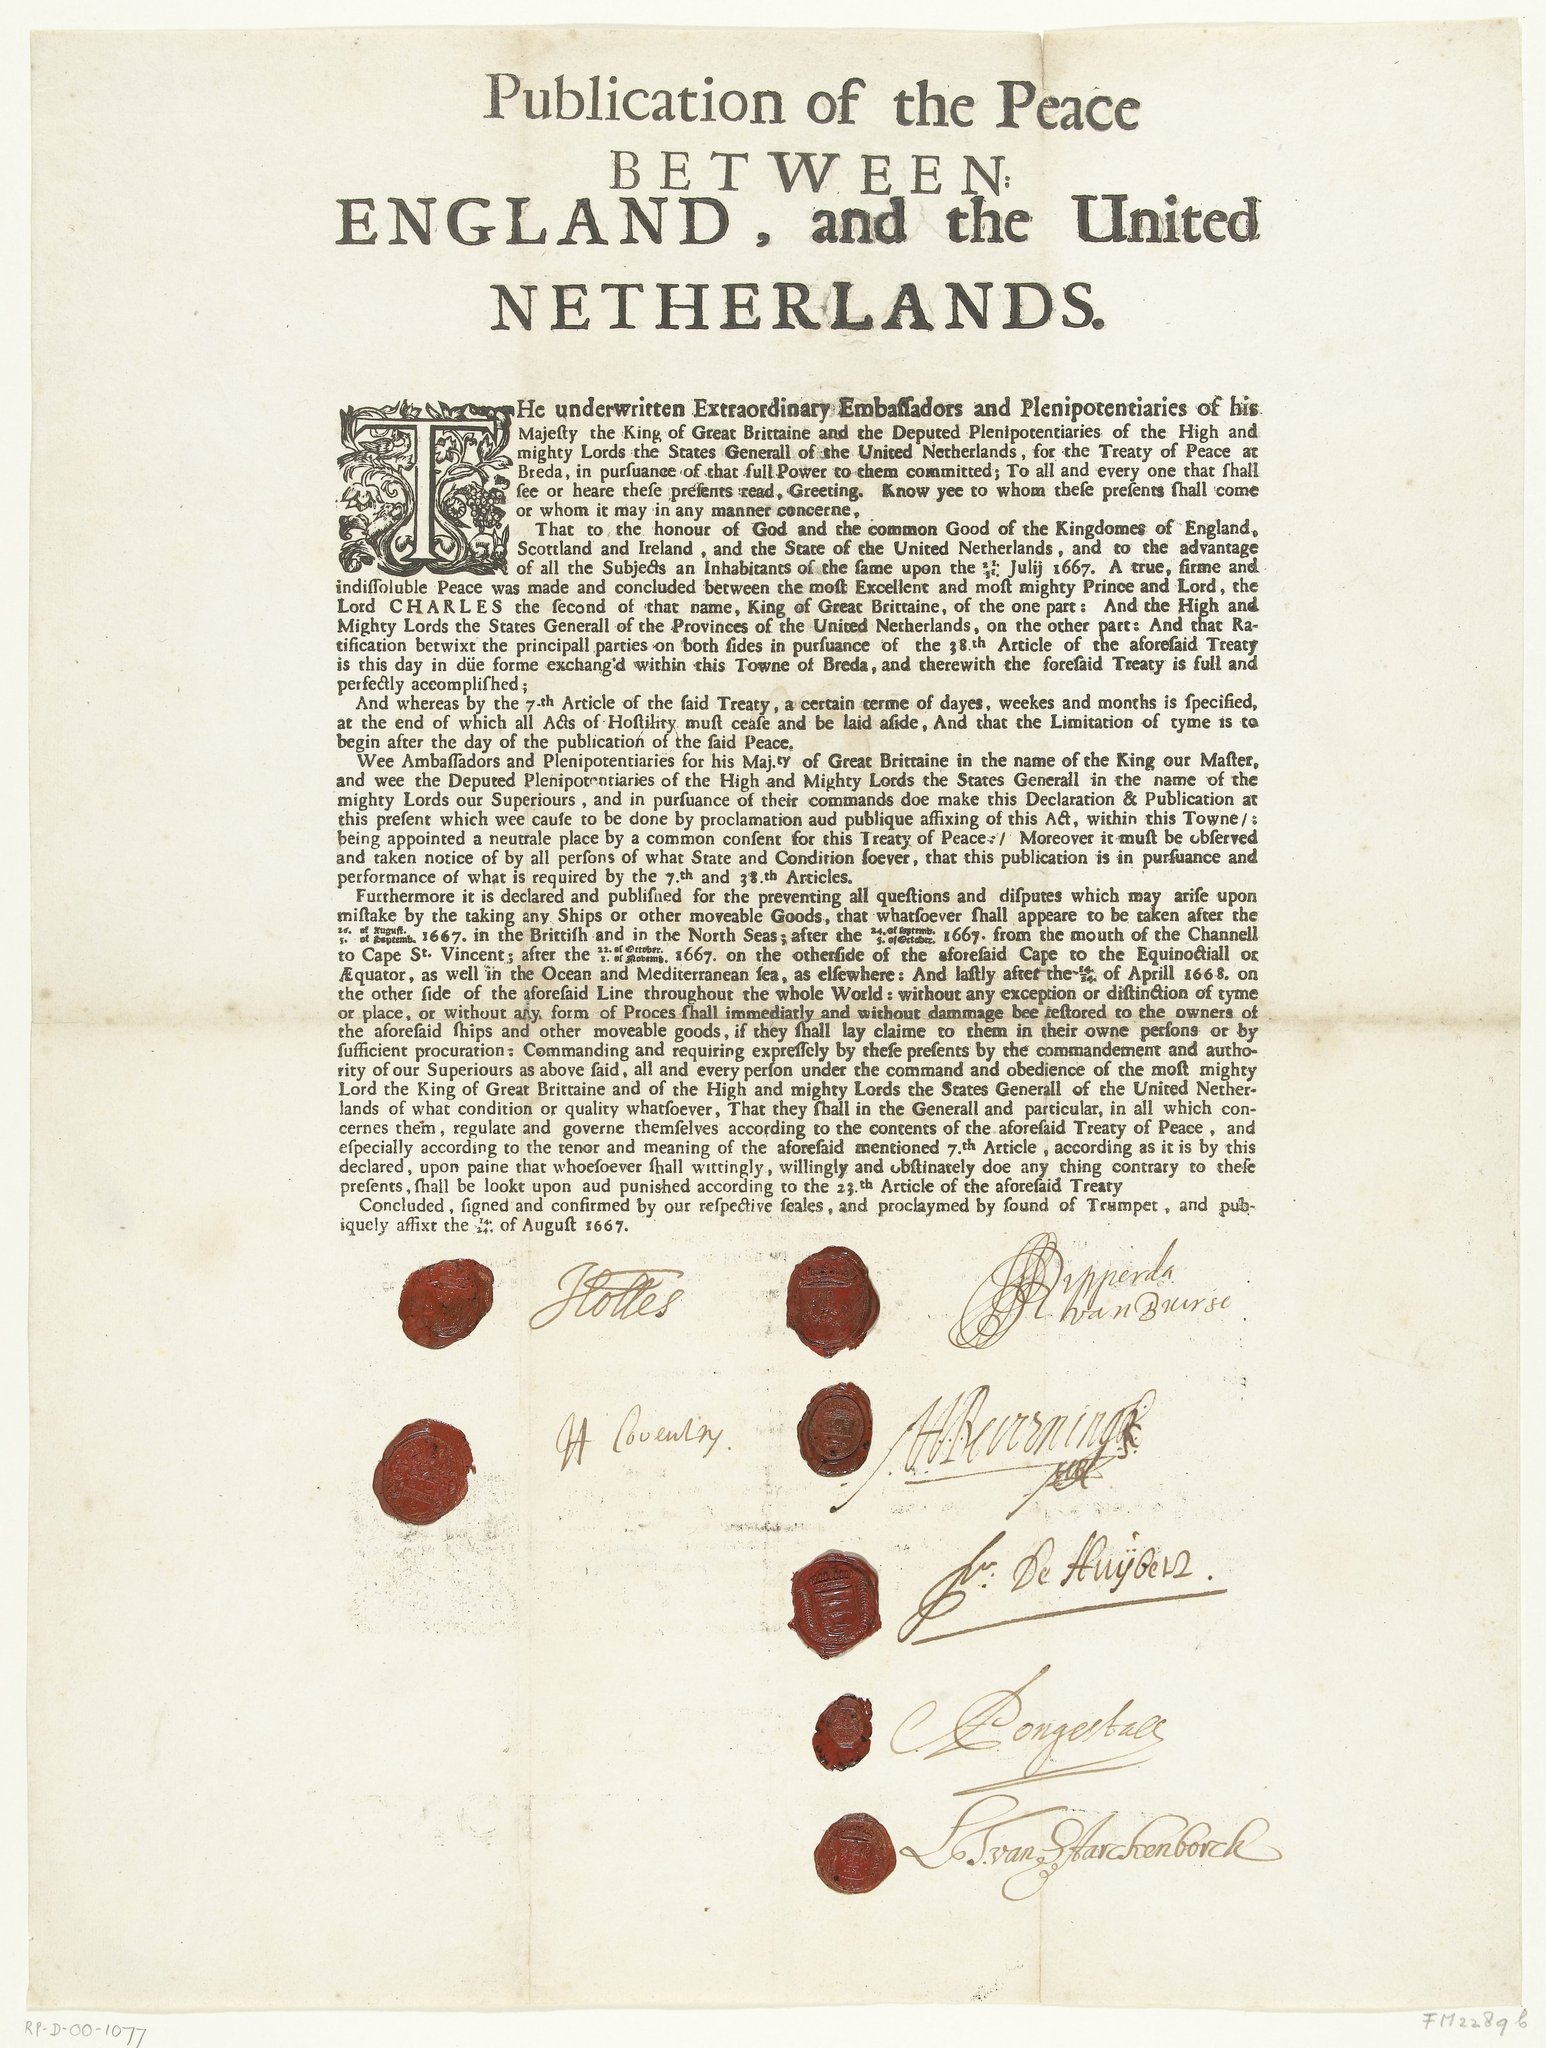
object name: document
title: Publicatie van de ratificatie van de Vrede te Breda, 1667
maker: Anonymous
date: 1608-1667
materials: paper, wax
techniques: printing, letterpress printing, writing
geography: breda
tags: vrede van breda (1667)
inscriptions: date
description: Originele publicatie van de ratificatie van de Vrede te Breda, gepubliceerd in het Nederlands op 24 augustus 1667. Met de handtekeningen en cachetten van de twee Engelse ambassadeurs D. Holles en H. Coventry en vijf Hollandse afgevaardigden Ripperda van Buirse, H. van Beverningh, Pr. de Huijbert, A.P. Jongestall en L.T. van Starckenborch.